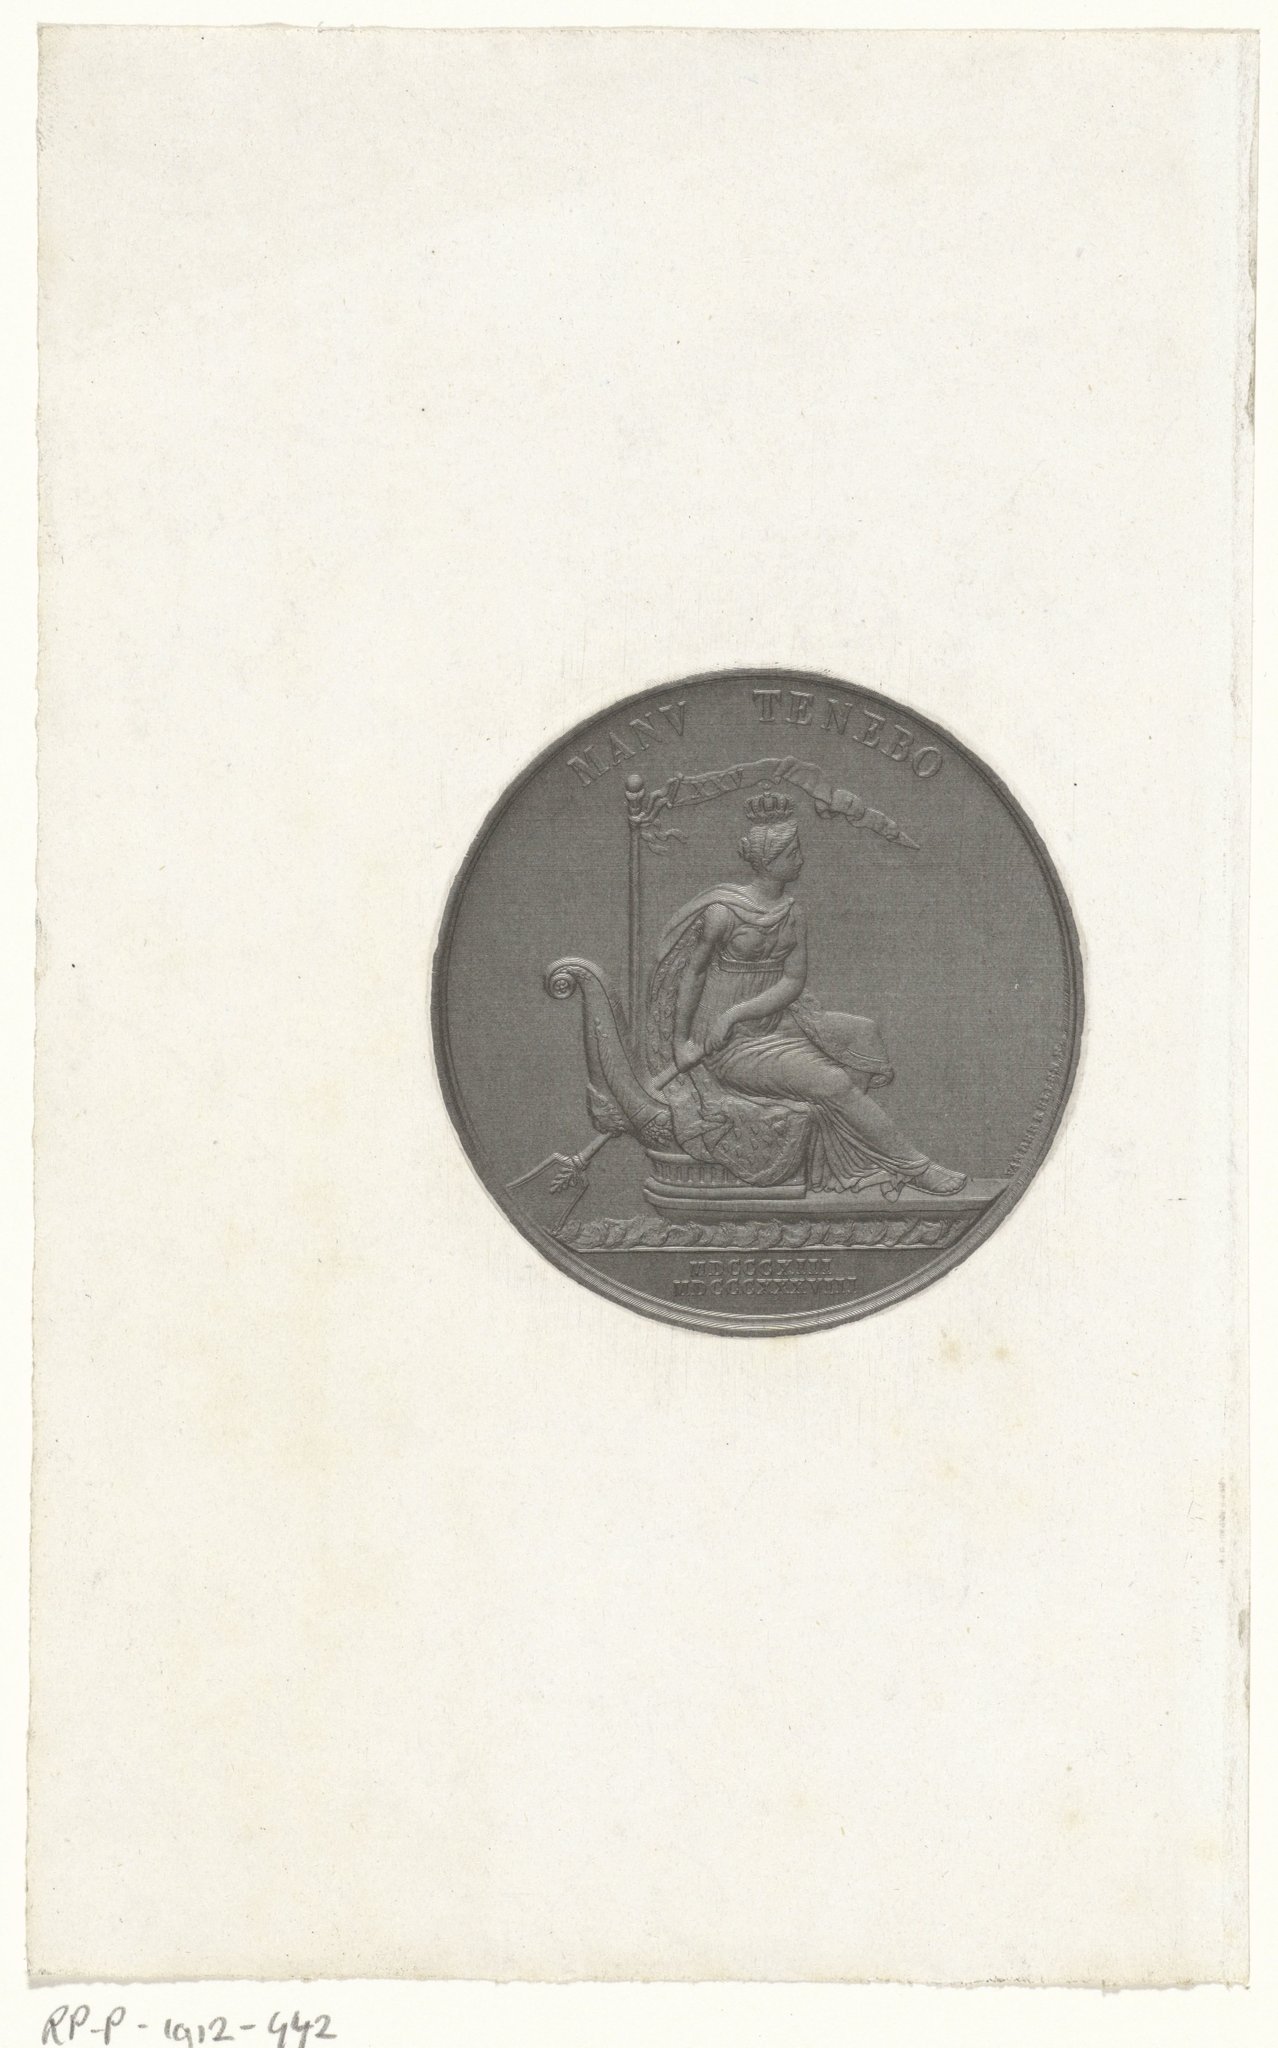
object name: print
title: Munt ter gelegenheid van jubileum koning Willem I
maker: jan dam steuerwald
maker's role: print maker, printer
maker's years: 1805-1869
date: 1838-1840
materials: paper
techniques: relief engraving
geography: netherlands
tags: coin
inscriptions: collector's mark: Lugt 2228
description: De achterzijde van een munt ter gelegenheid van het 25-jarig koningsschap van Willem I. Op de munt de gekroonde Hollandse maagd.